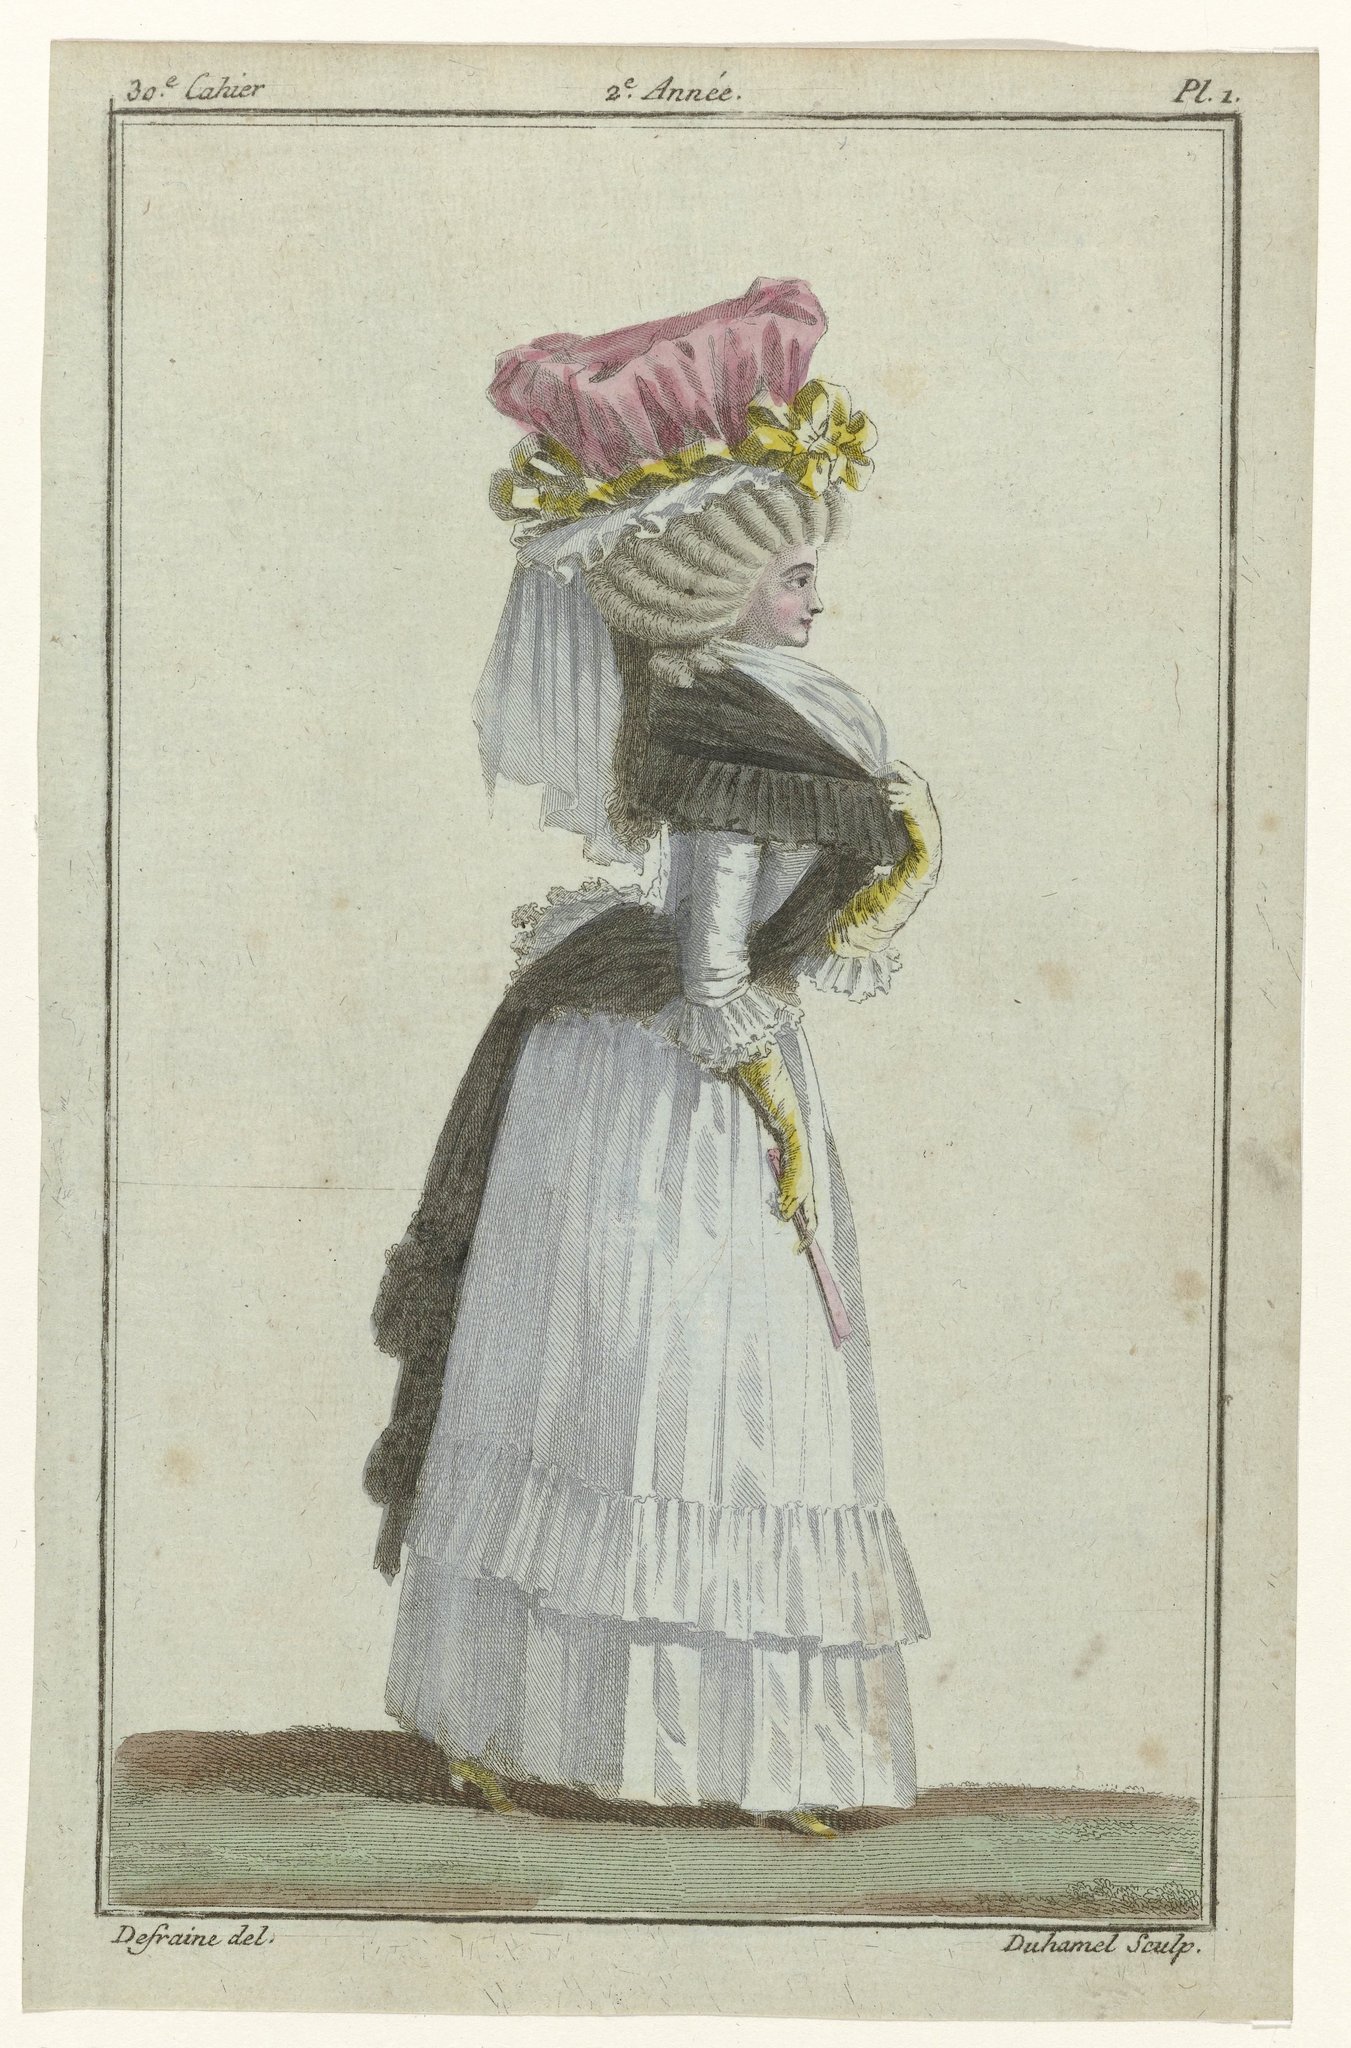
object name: fashion print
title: Magasin des Modes Nouvelles Françaises et Anglaises, 10 septembre 1787, 30e cahier, 2e année, Pl. 1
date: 1787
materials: paper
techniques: engraving, hand coloring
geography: paris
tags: clothing for the upper part of the body (caraco) (+ women's clothes), gloves, mittens (long gloves) (+ women's clothes), head-gear: cap (+ women's clothes), fashion plates, shoes, sandals (+ women's clothes), skirt (+ women's clothes), sleeves: cuffs (+ women's clothes), fan (+ women's clothes), piece of clothing covering the breast or décolleté (fichu) (+ women's clothes)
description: Vrouw naar rechts, in caraco van mousseline op een rok, versierd met een gerimpelde strook stof. Fichu en kleine schoudermantel (?) afgezet met een gerimpelde strook. Gerimpelde dubbele manchetten. Accessoires: grote muts met lint en afhangende slip, lange handschoenen, waaier, schoenen met hakken. De prent maakt deel uit van het 30e Cahier, 2e année, uit de serie Magasin des Modes Nouvelles Françaises et Anglaises. De serie bestaat uit 172 modeprenten, uitgegeven door Buisson, Parijs, 20 novembre 1786 - 21 décembre 1789.